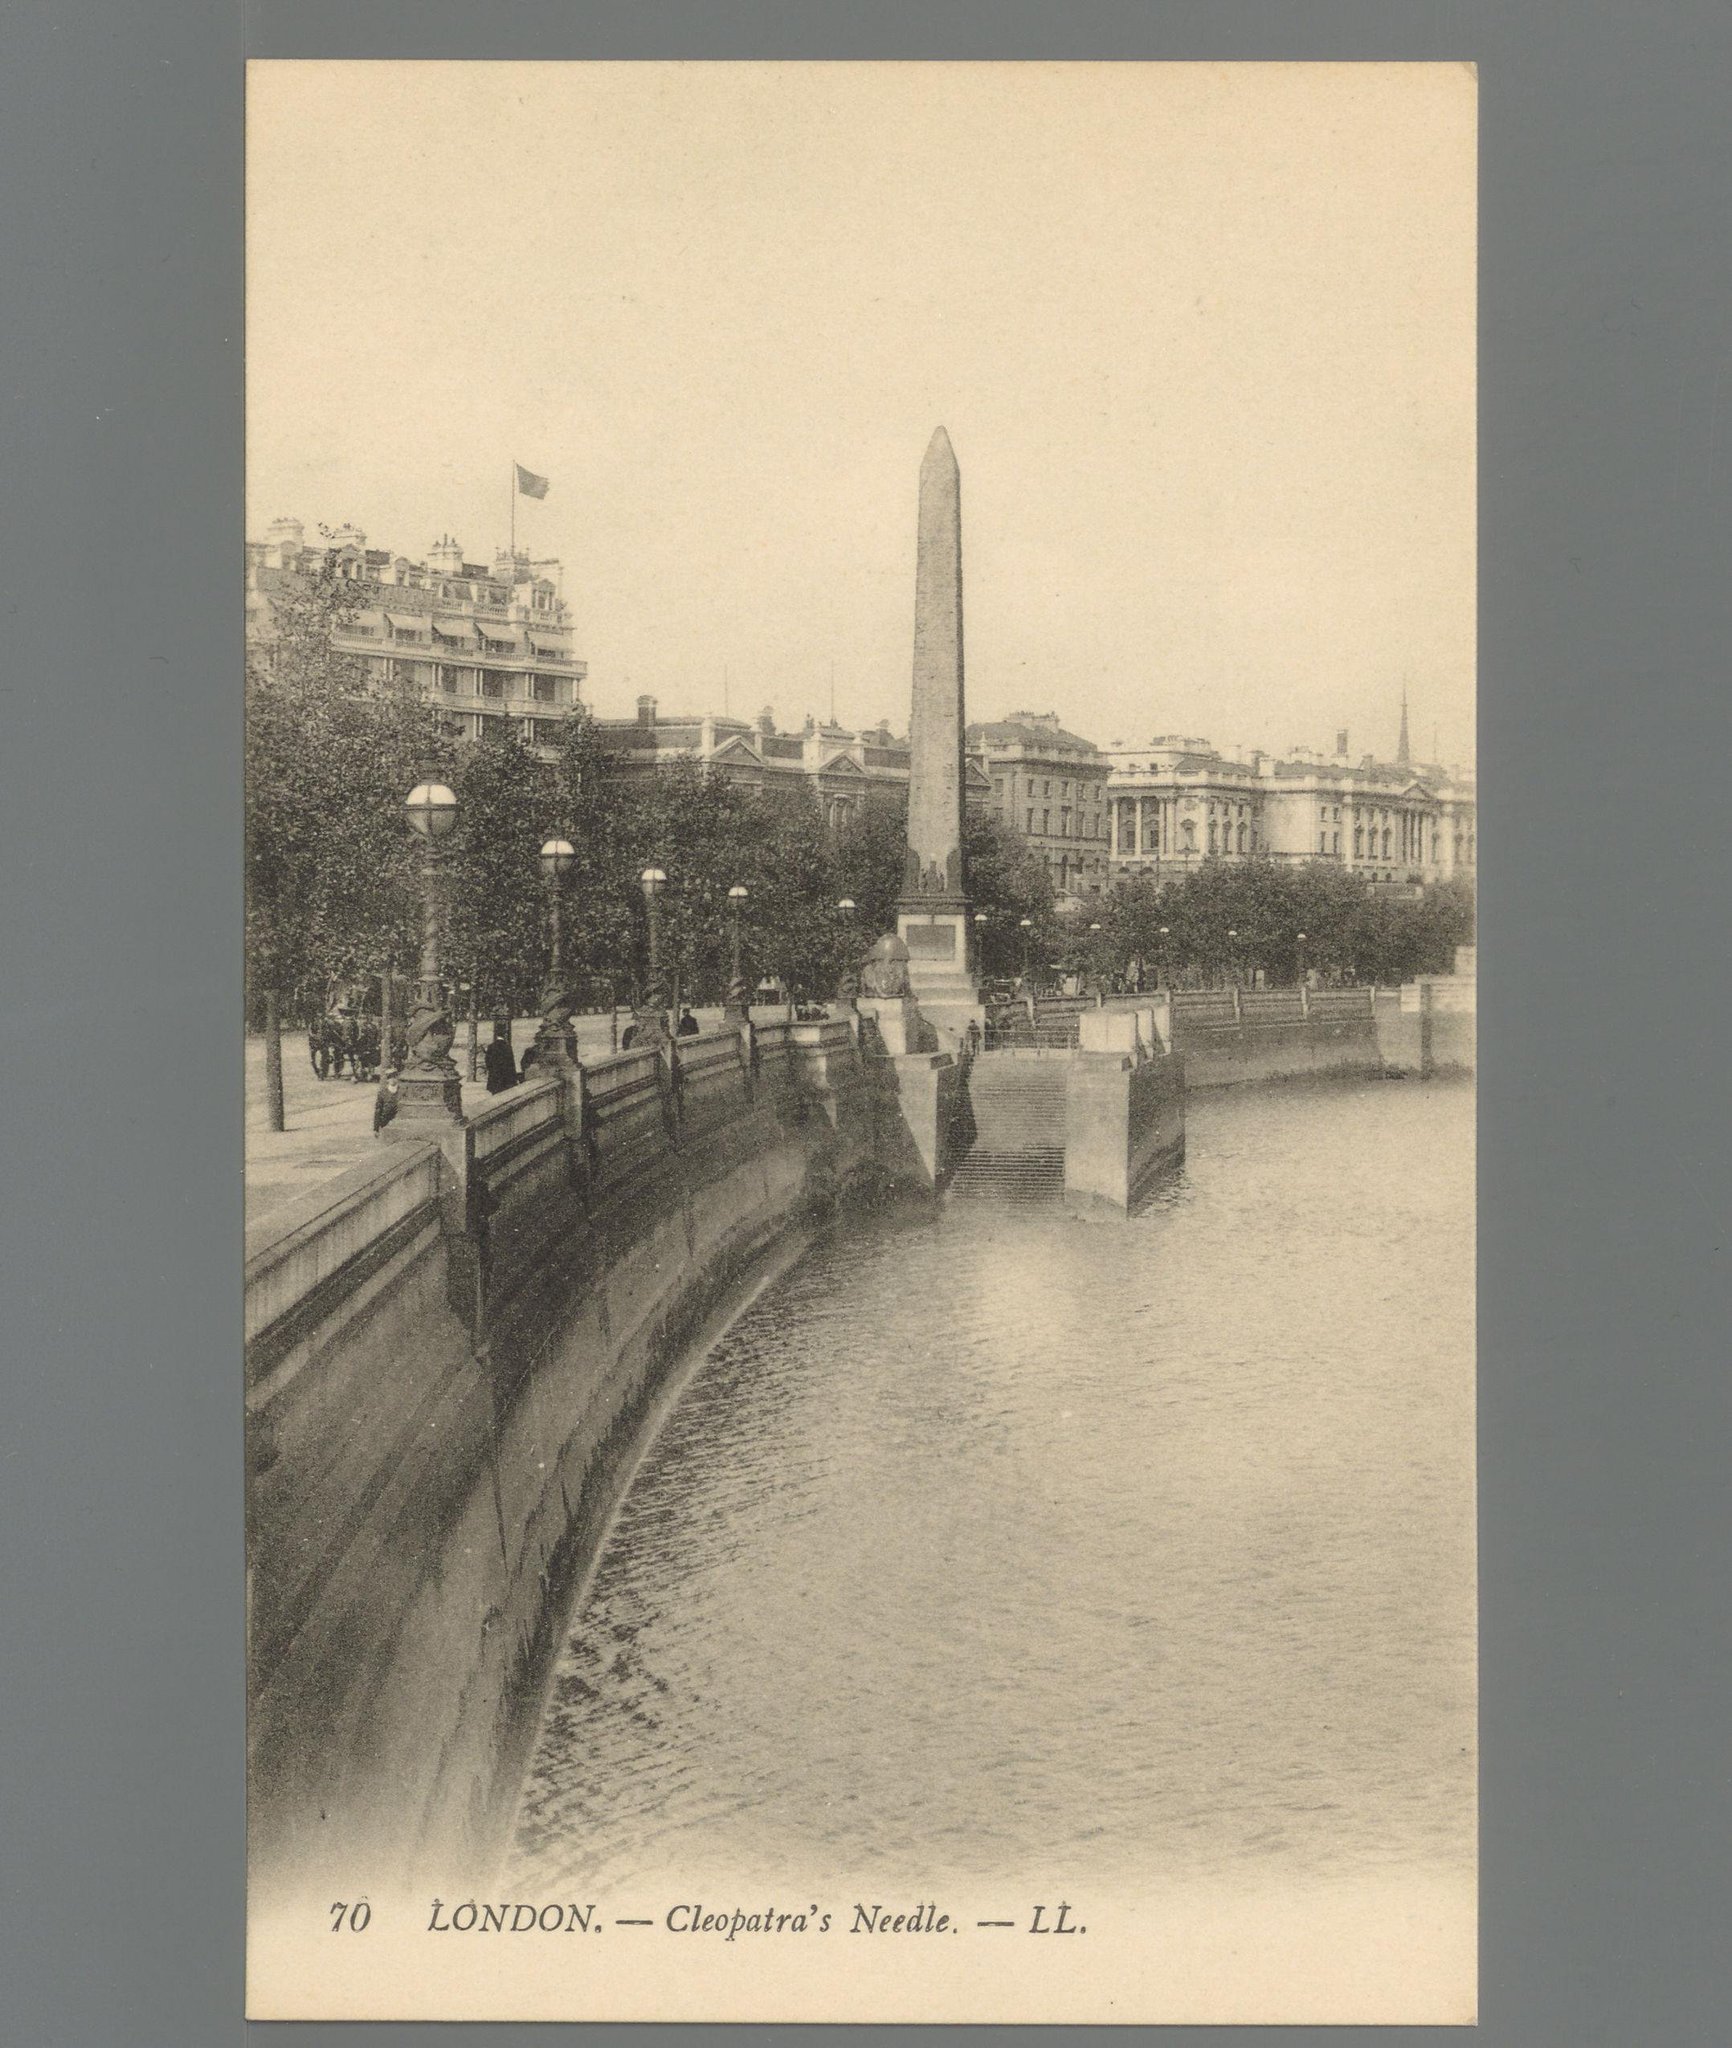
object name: ansichtkaart, prentbriefkaart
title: London. - Cleopatra's Needle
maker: Anonymous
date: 1902-1918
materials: cardboard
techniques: photograph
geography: london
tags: obelisk, needle, canals, waters (in city), quay, thames